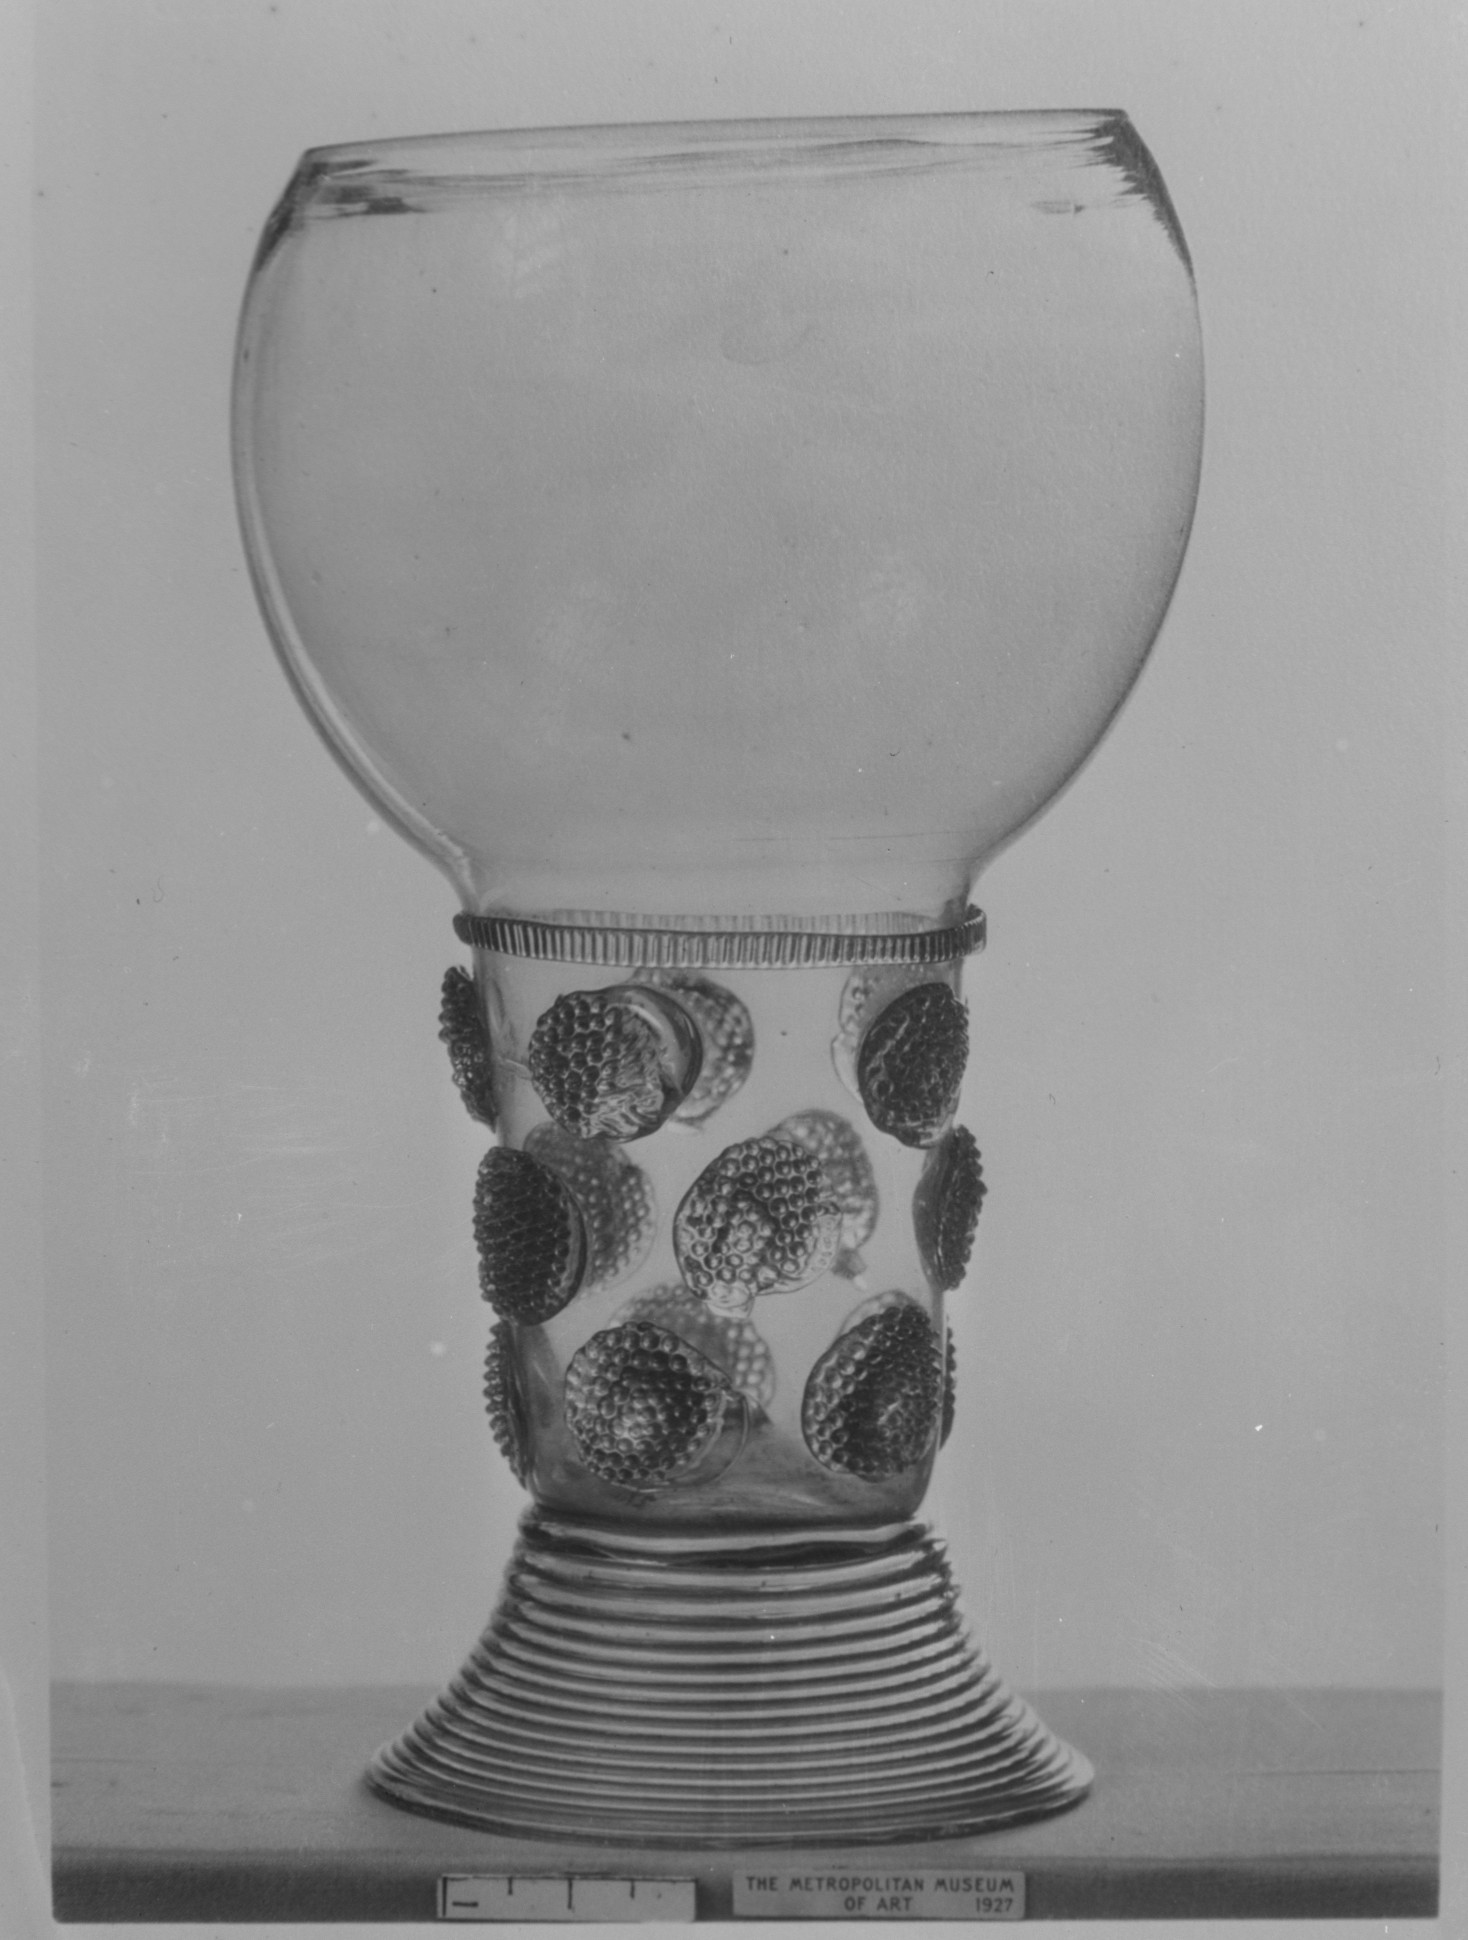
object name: goblet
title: Goblet (Roemer)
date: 1601-1700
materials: glass